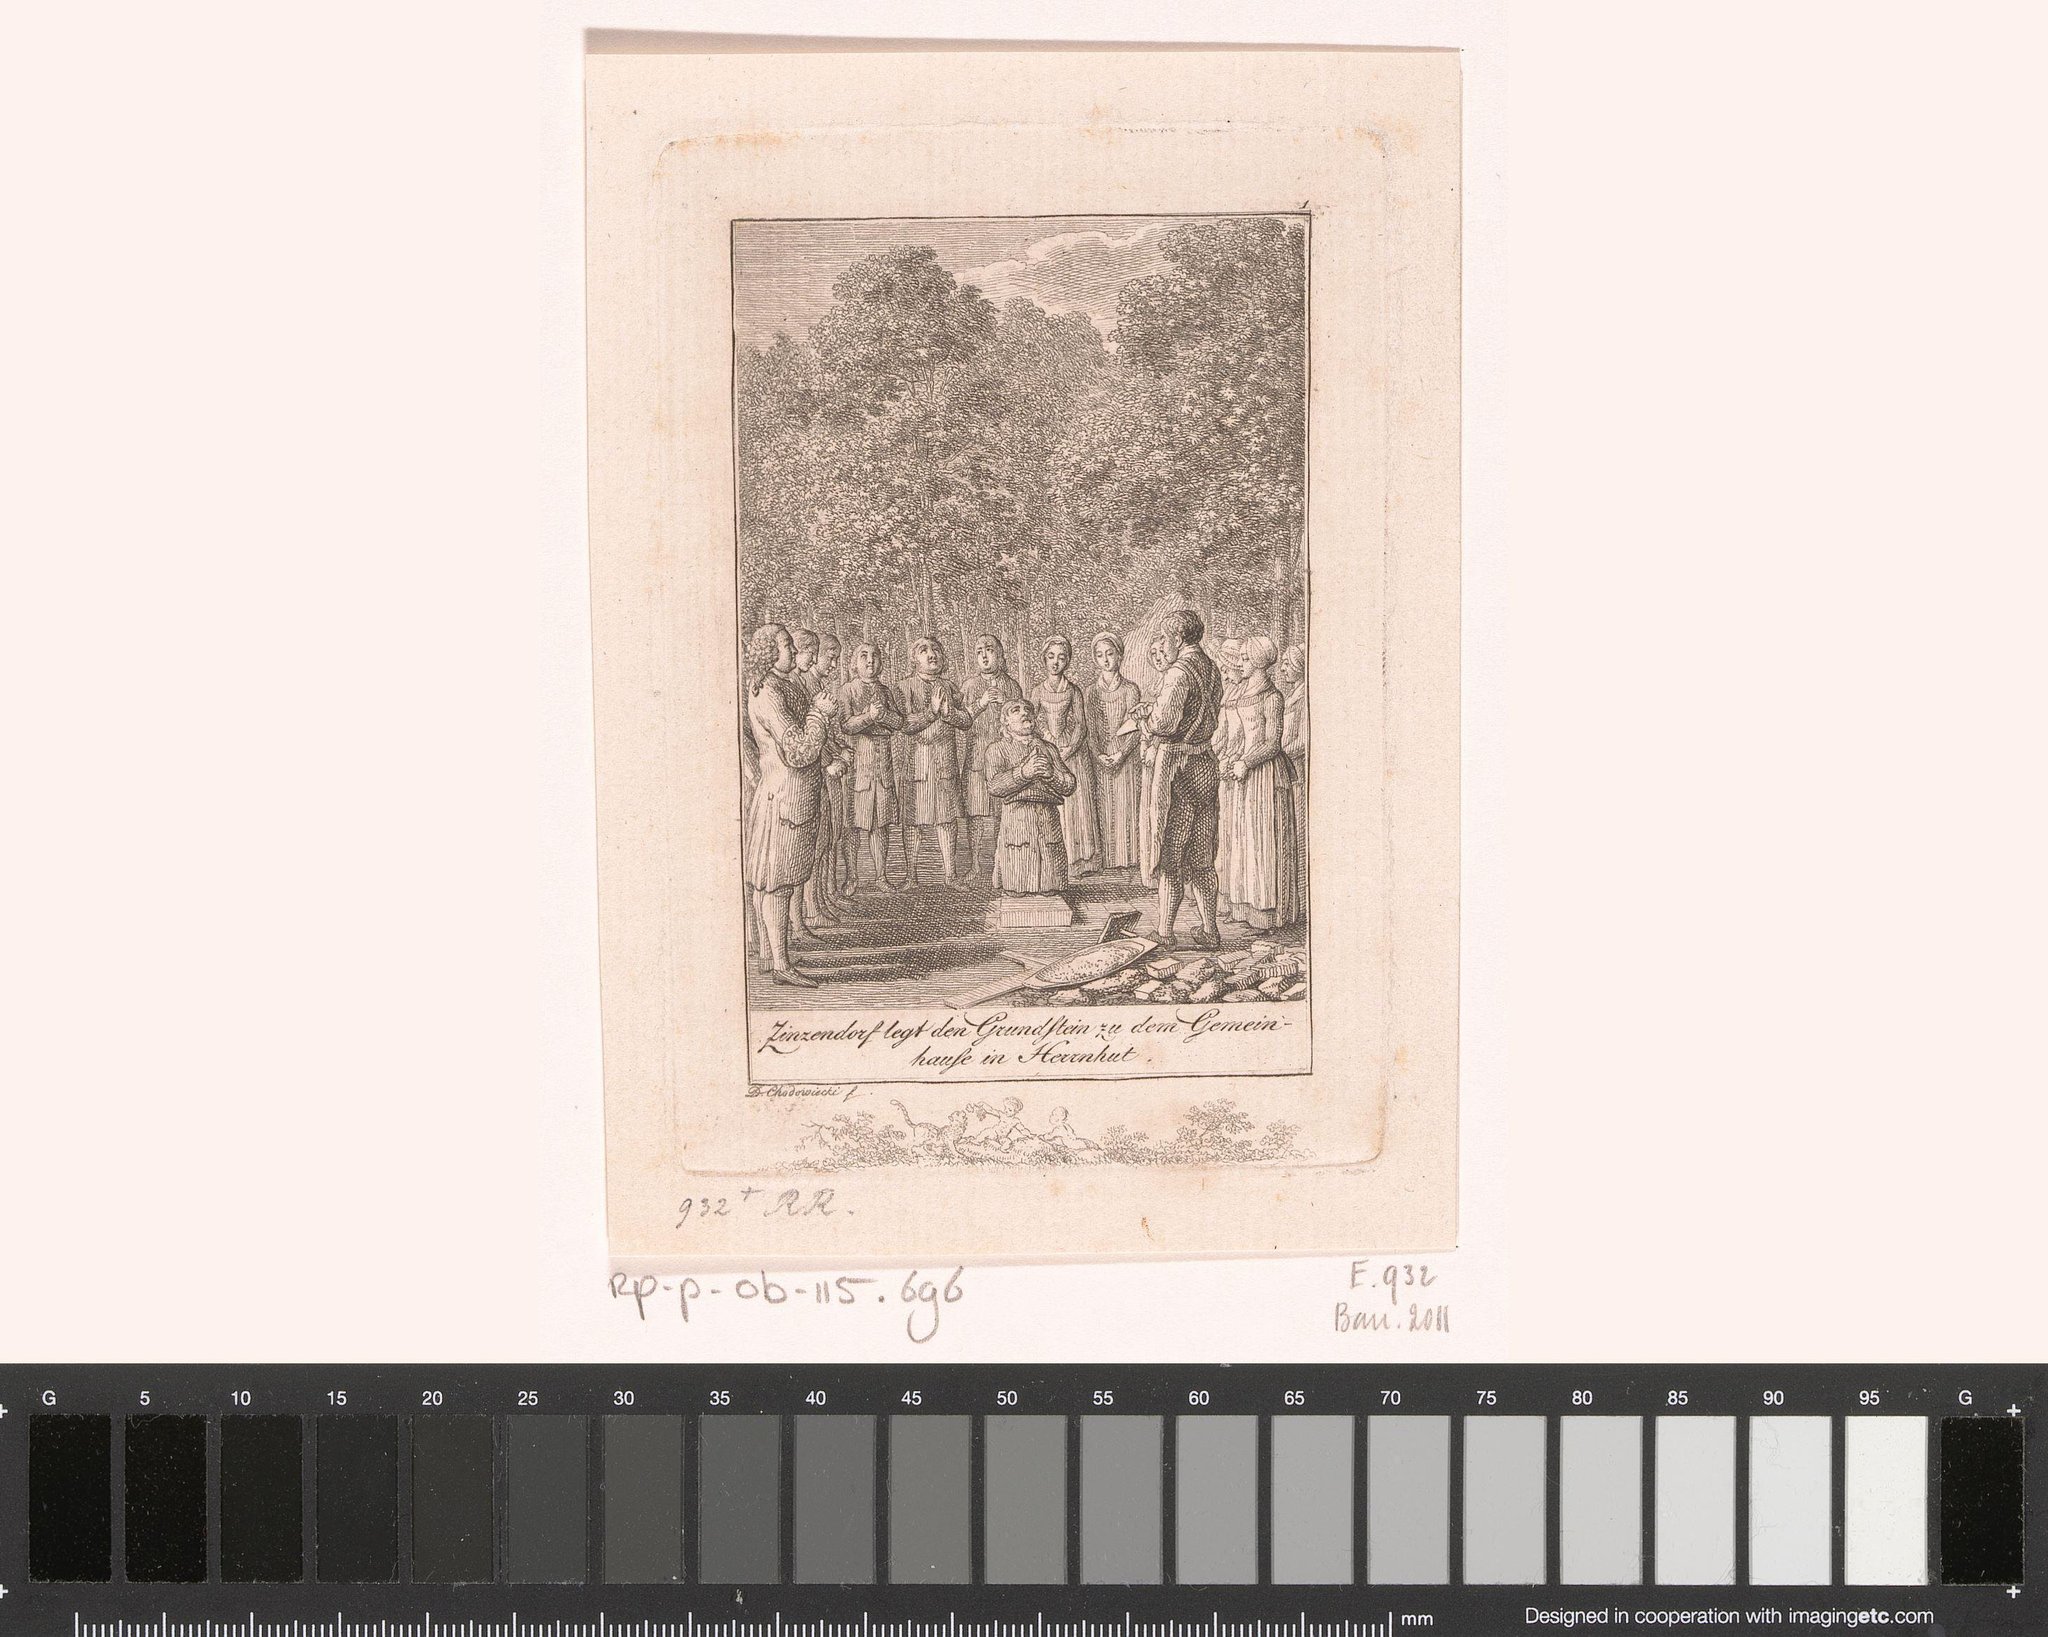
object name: print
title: Zinzendorf legt de eerste steen voor de gemeenschap Herrnhut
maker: daniel nikolaus chodowiecki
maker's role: draughtsman, print maker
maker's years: 1726-1801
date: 1800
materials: paper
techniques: etching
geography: berlin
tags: earl, ceremonial laying of the foundations, laying the first stone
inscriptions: collector's mark: Lugt 2228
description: Prent gebruikt voor: Salzmann, Christian Gotthilf. Taschenbuch zur Beförderung der Vaterlandsliebe. Auf das Jahr 1801 (...). Schnepfenthal: s.n., 1801.